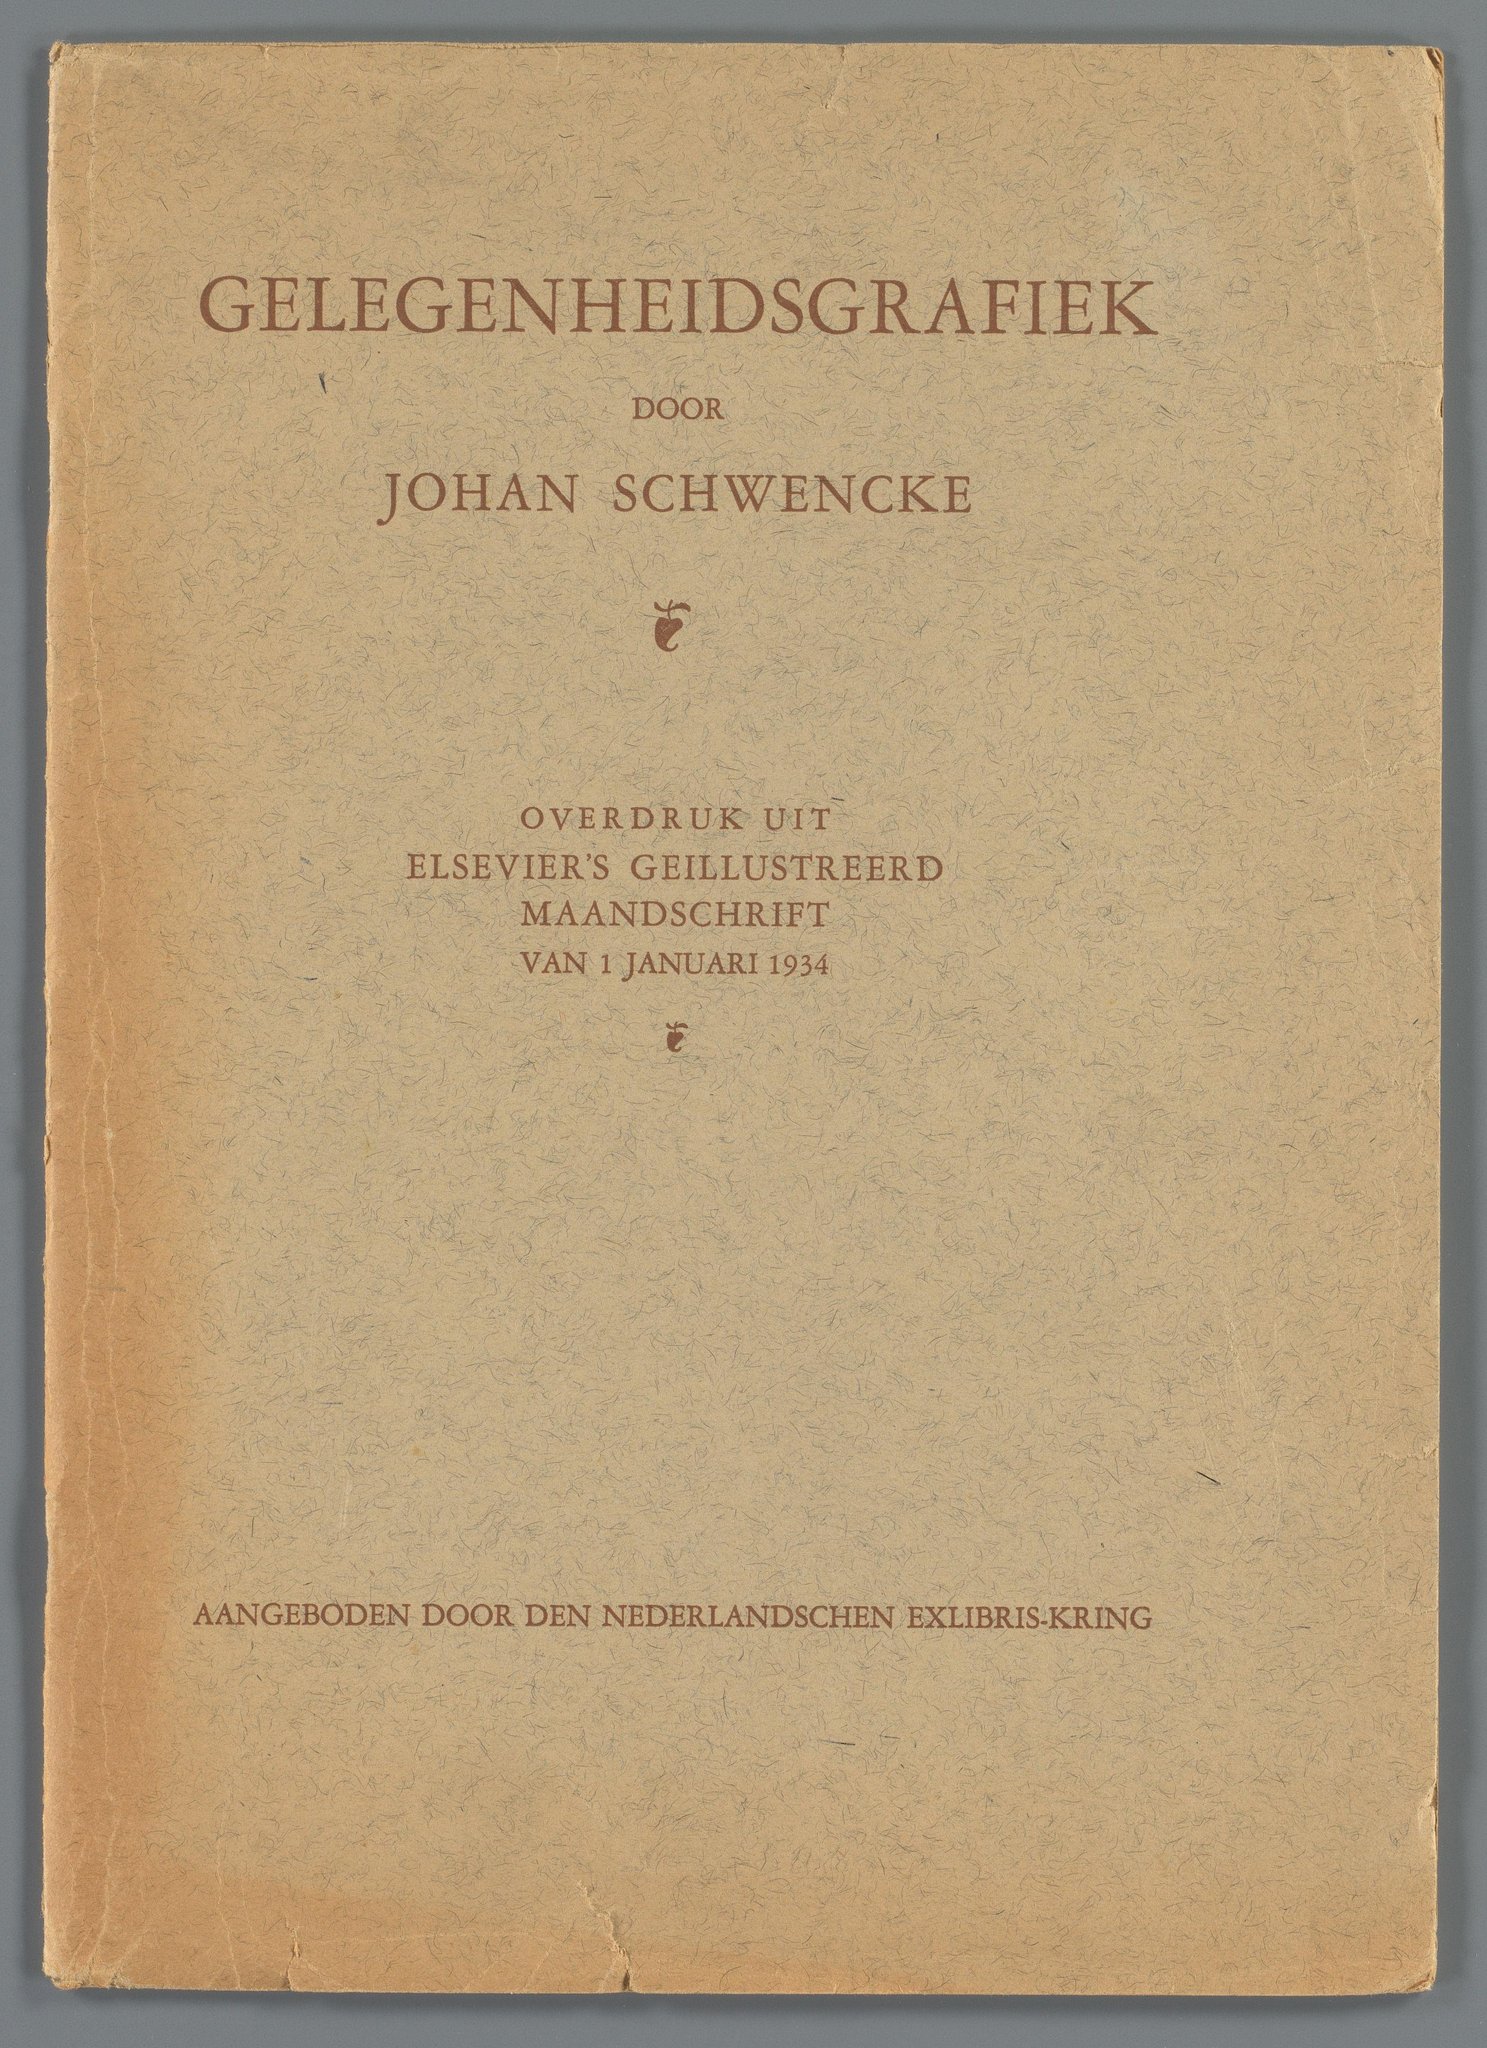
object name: magazine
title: Gelegenheidsgrafiek (familieberichten e.d. als voortbrengselen van grafische kunst)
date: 1901-1934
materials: paper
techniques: stapling, engraving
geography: the hague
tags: the graphic arts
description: Publicatie van zestien pagina's, met daarvoor een houtgravure door Willem van Rozendaal, in de tekst zeven pagina's met fotomechanische reproducties van gelegenheidsgrafiek in diverse grafische technieken. Aan het eind van de tekst een houtsnede door Wiktorya Gorýnska. Overdruk van het artikel zoals dat eerder gepubliceerd werd in 'Elsevier's geïllustreerd maandschrift', 1 januari 1934.